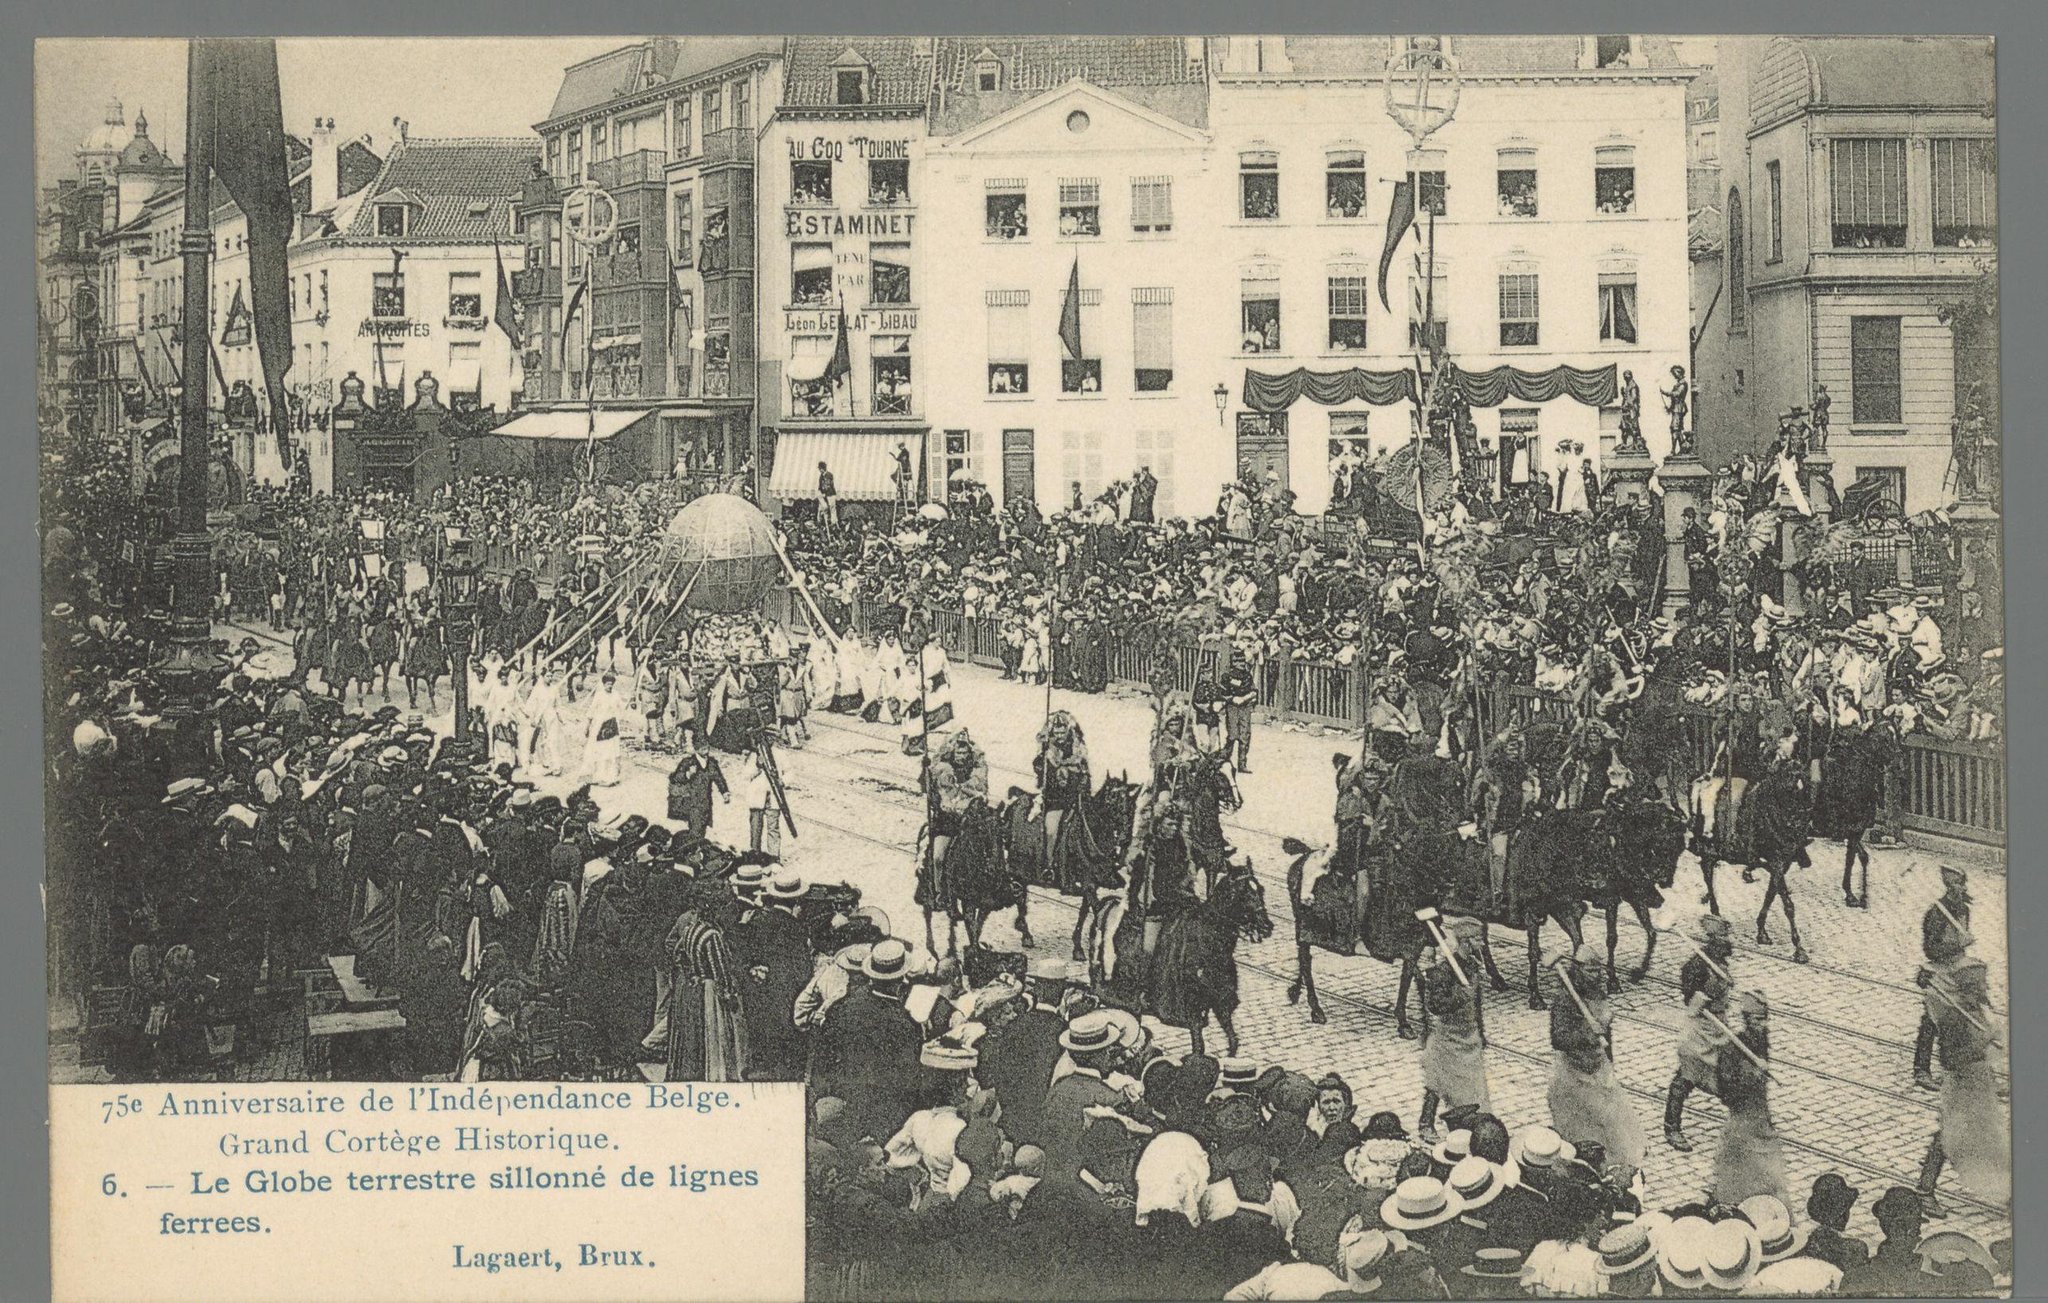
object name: ansichtkaart, prentbriefkaart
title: 75e Anniversaire de l'Indépendance Belge. Grand Cortège Historique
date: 1905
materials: cardboard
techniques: photograph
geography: schaarbeek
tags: city-view, and landscape with man-made constructions (+ city(-scape) with figures, staffage), periodic celebrations, popular feasts, brussels